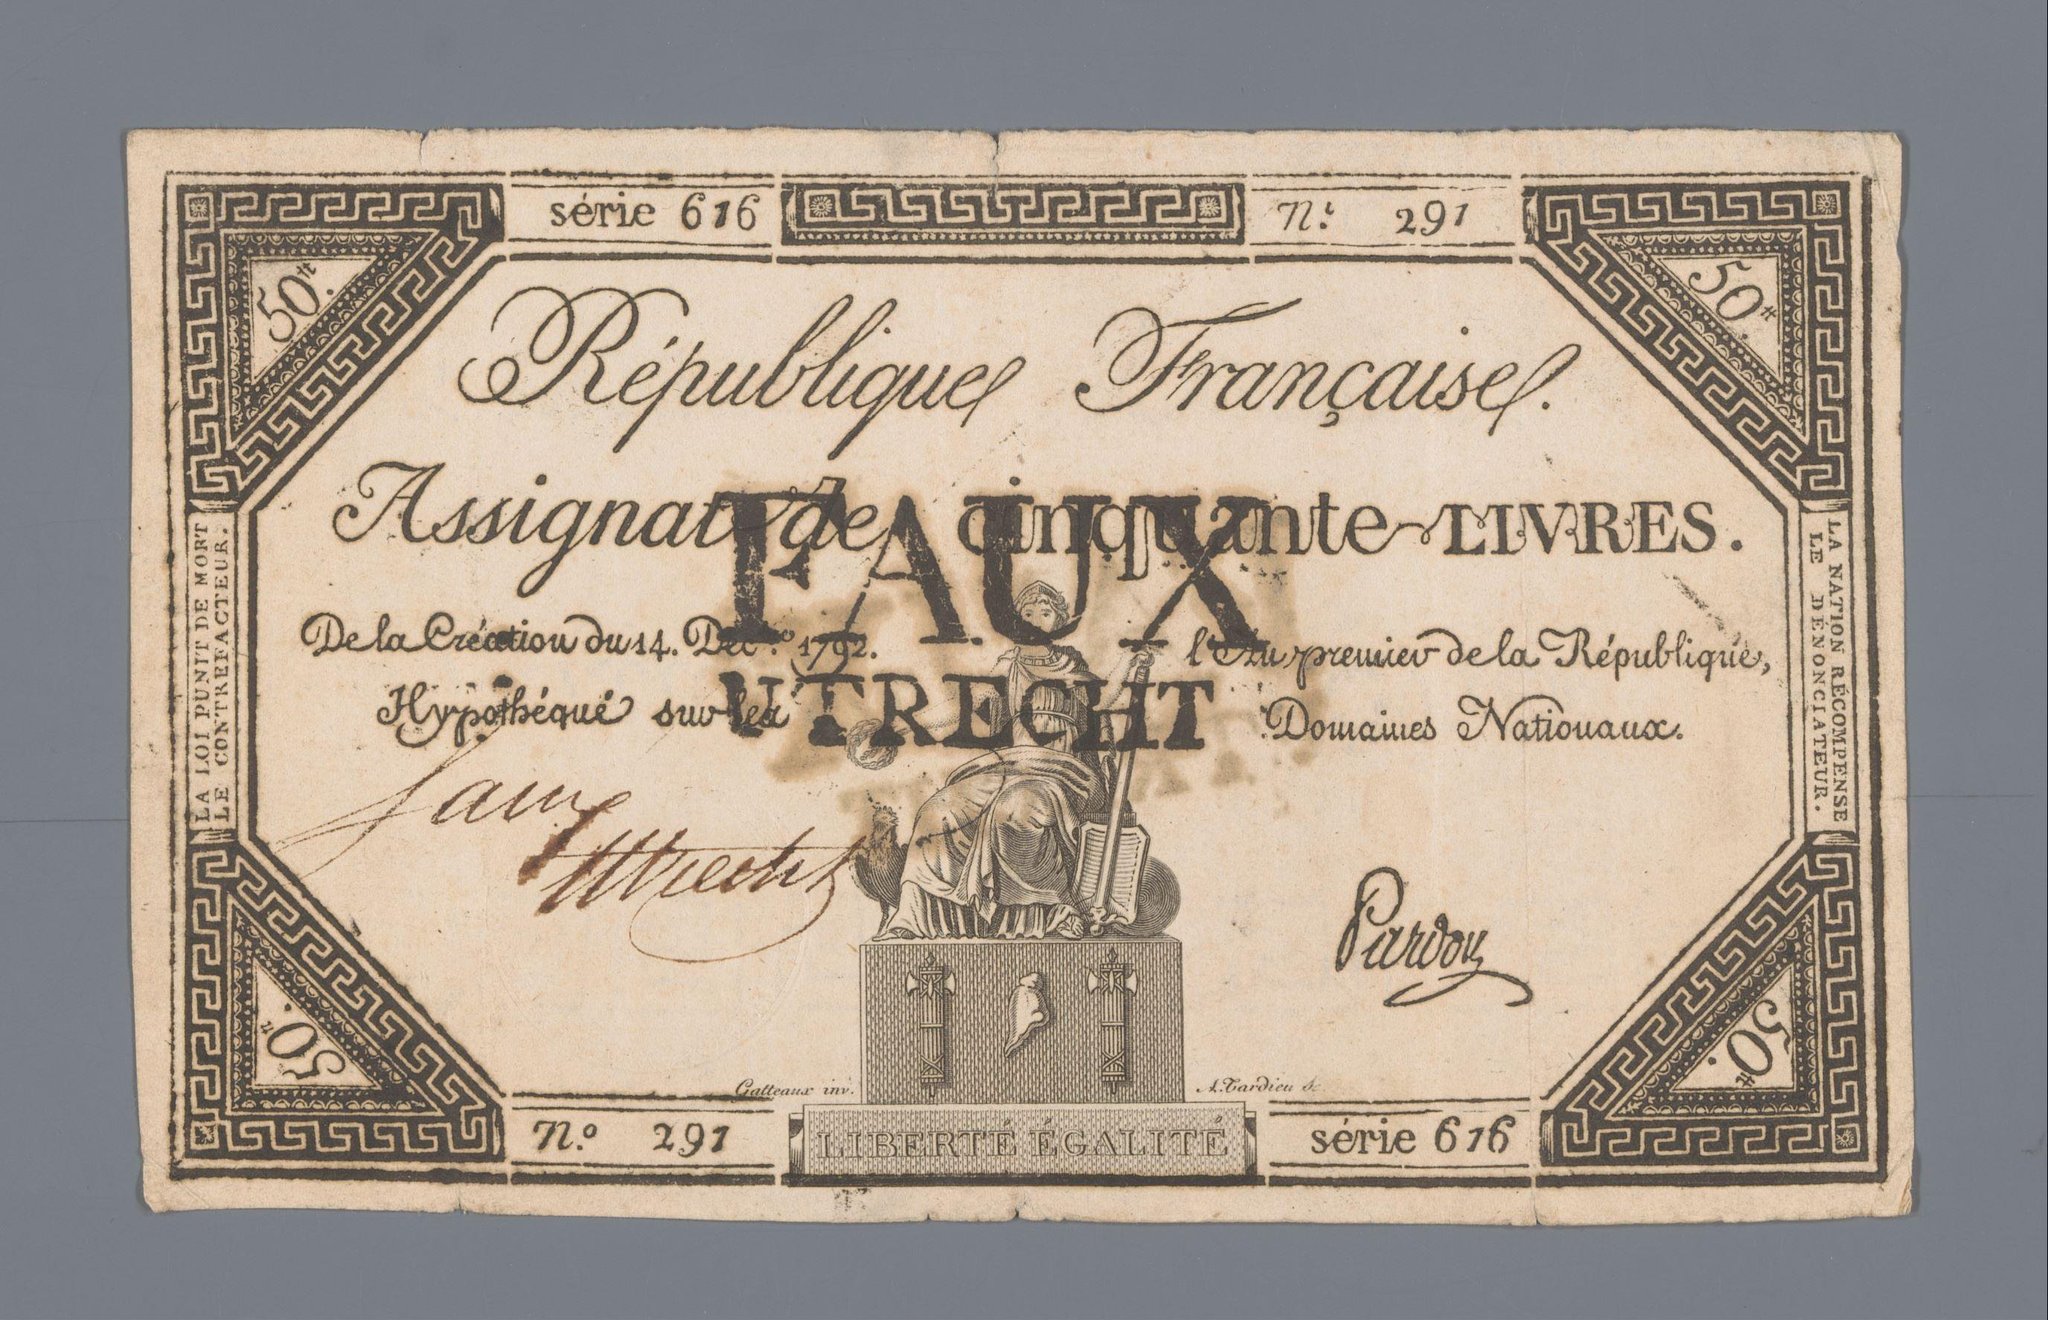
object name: assignat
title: Te Utrecht ongeldig gemaakte assignat van vijftig livres, serie 616, nr. 291 uitgegeven 14 december 1792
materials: paper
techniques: printing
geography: france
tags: utrecht, france